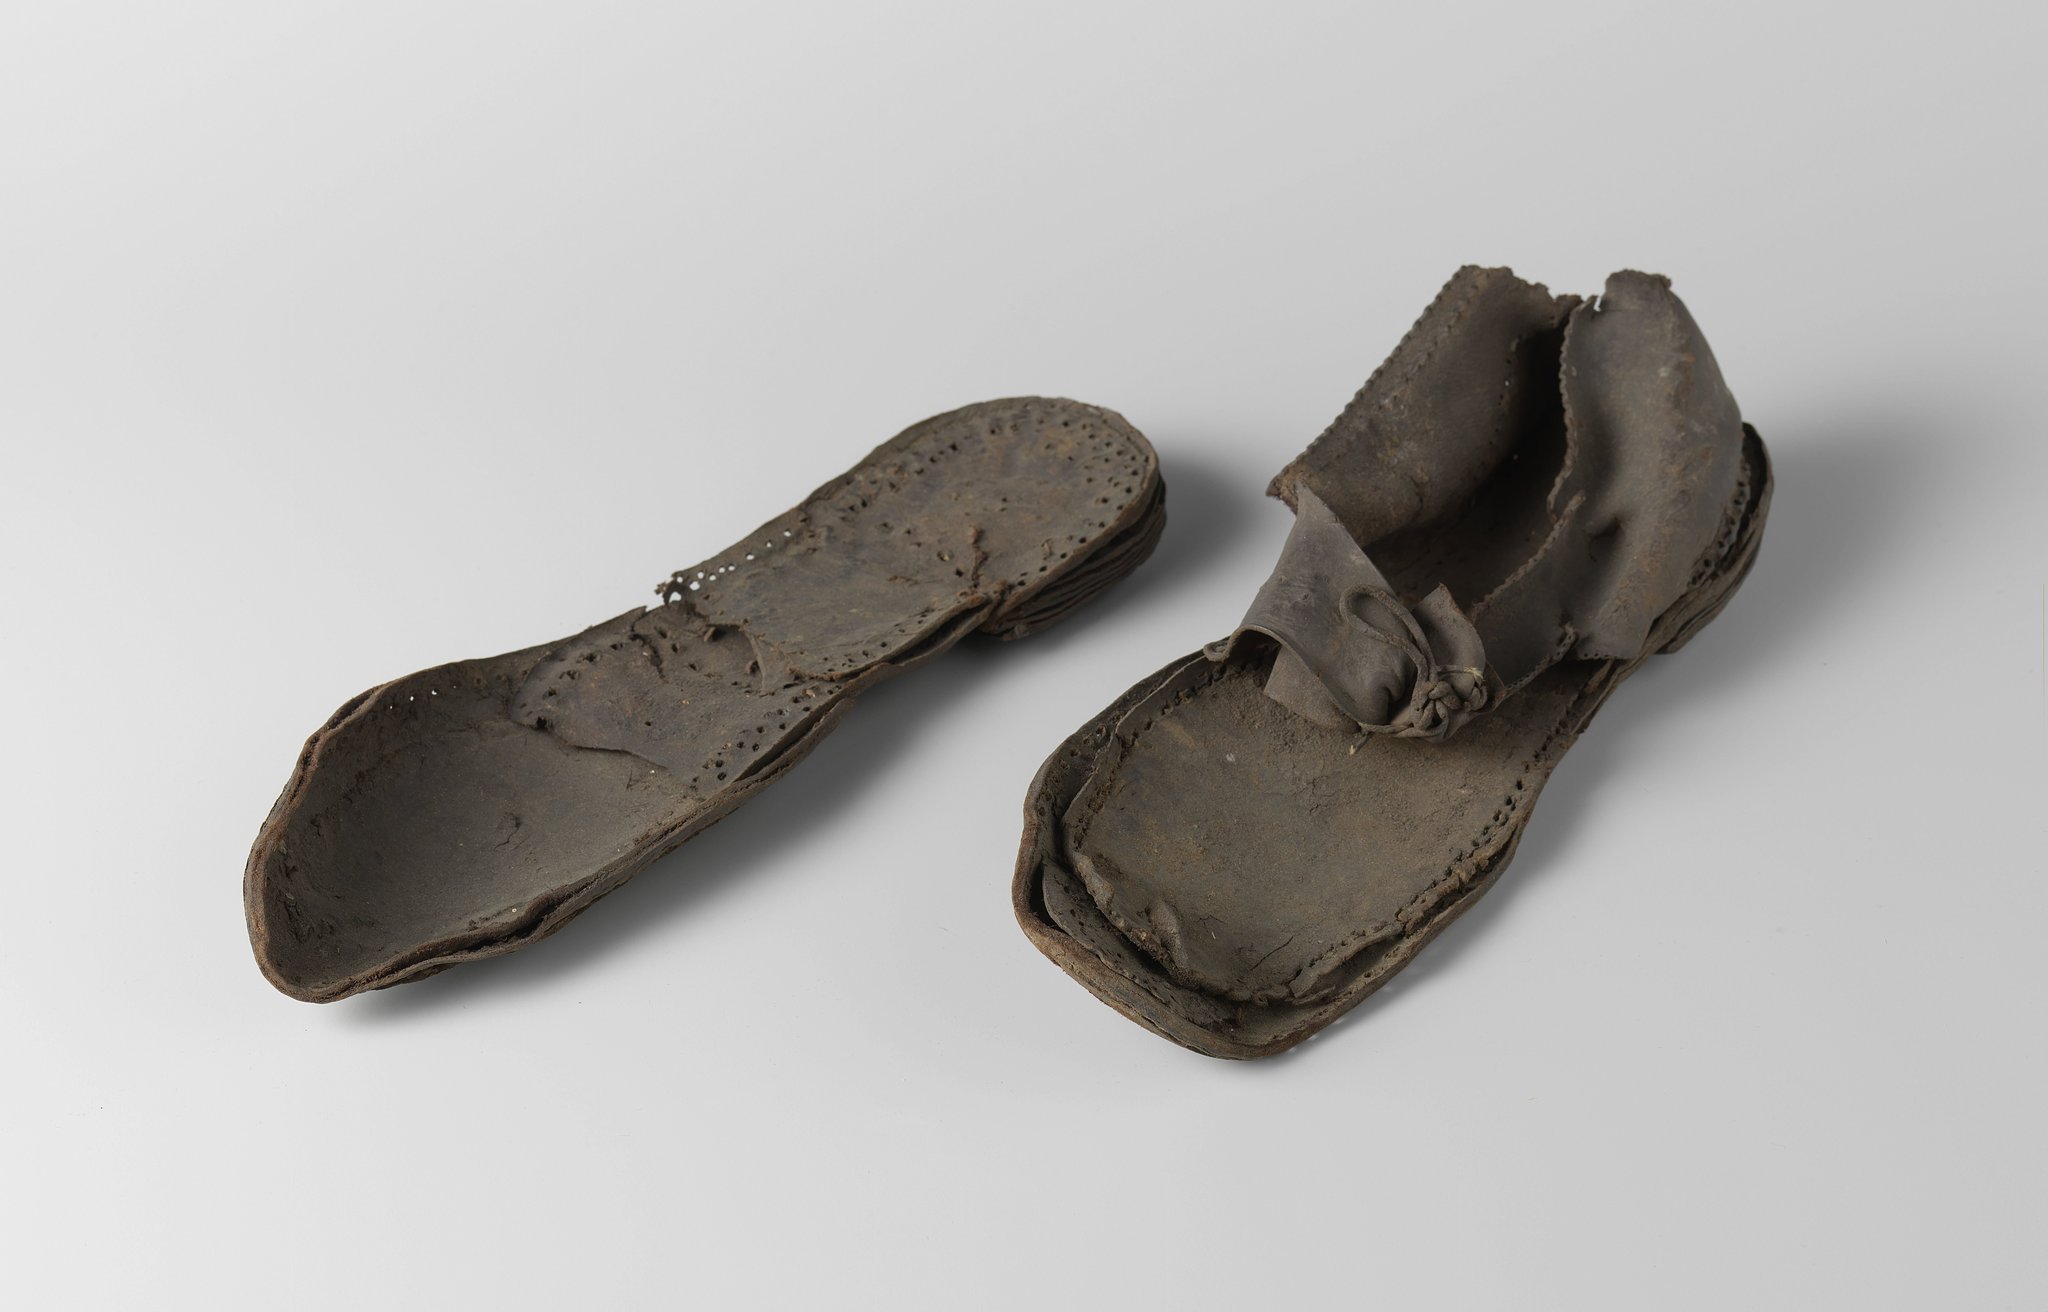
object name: womenswear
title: Leren damesschoen, gedragen door freule Johanna Magdalena Catharina Judith van Dorth tot Holthuysen tijdens haar executie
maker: Anonymous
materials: iron, leather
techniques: nailed, sewing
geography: netherlands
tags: johanna magdalena catharina judith van dorth, winterswijk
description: Gedragen door freule Judith van Dorth tot Holthuysen, stiftsjuffer te Grevelsberg, bij haar executie te Winterswijk, 24 november 1799 's morgens tussen tien en elf uur. Zij werd ter dood veroordeeld door de krijgsraad, opgericht door de fransman Girod, wegens haar geuite sympathieën voor Oranje. Afkomstig uit het graf van de freule in de N.H. kerk te Lichtenvoorde. De schoenen werden aangetroffen in 1929 toen bij een verbouwing van de kerk van Lichtenvoorde het graf van Freule Judith van Dorth tot Holthuizen werd gevonden. Zij bleef in de Franse Tijd openlijk loyaal aan de Oranjes, en werd in 1799 door de Patriotten gearresteerd, berecht en geexecuteerd. Het lichaam is vervolgens herbegraven; haar schoenen en de blinddoek die ze droeg zijn echter bewaard.